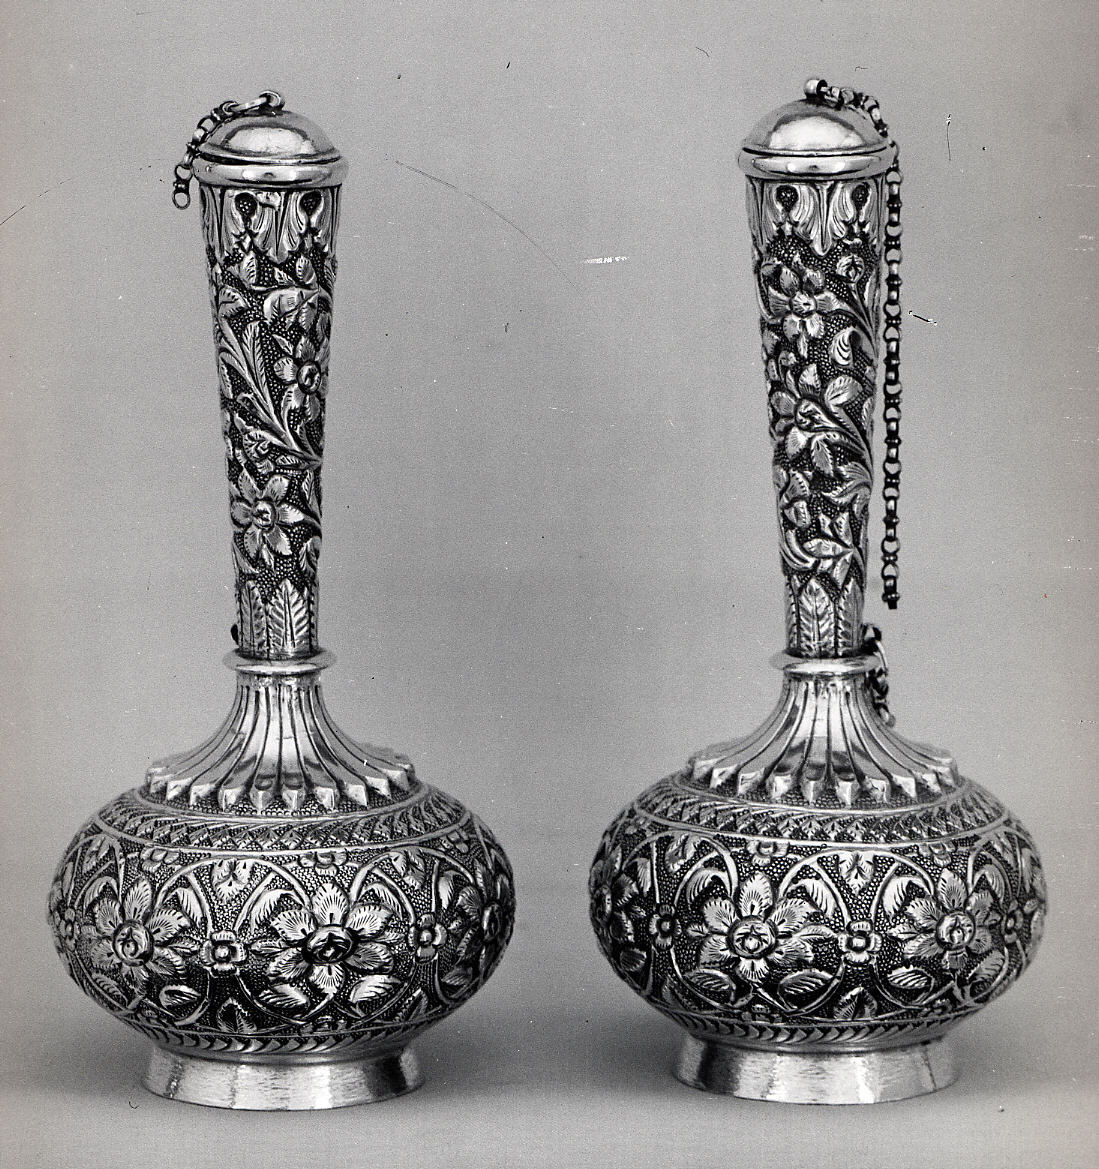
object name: bottle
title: Bottles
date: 1701-1800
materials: silver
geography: india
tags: flowers